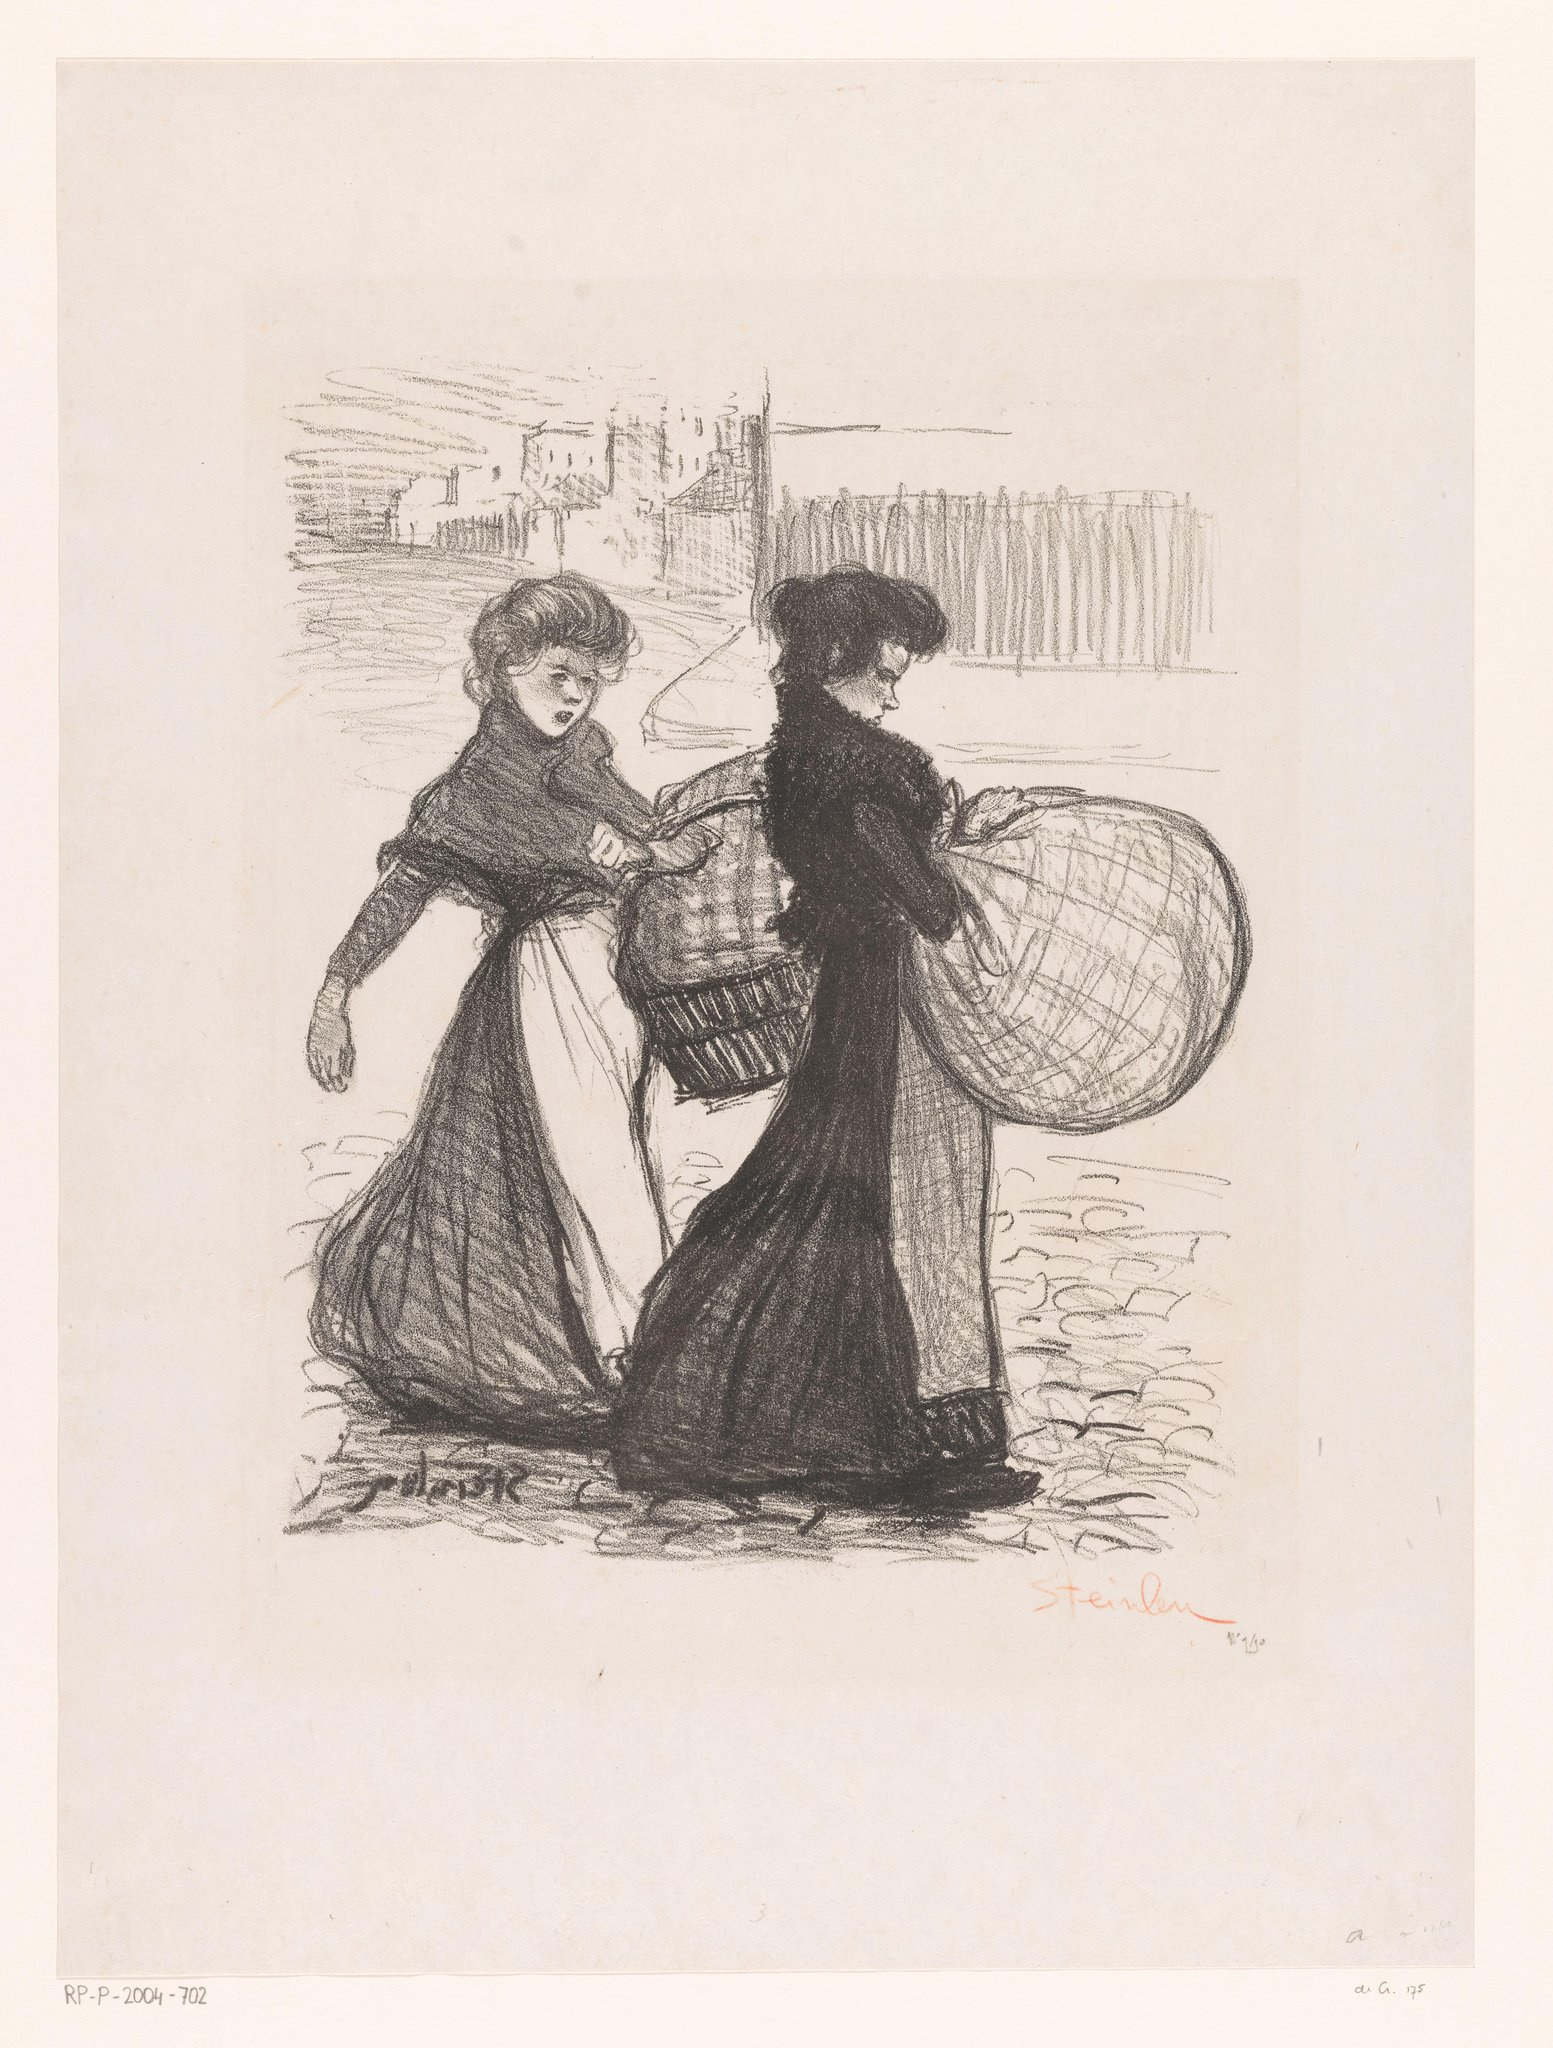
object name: print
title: Blanchisseuses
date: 1896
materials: paper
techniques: lithograph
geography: paris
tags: adult woman, household chores, street, house personnel, servants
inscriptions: stamp, collector's mark: Lugt 2228